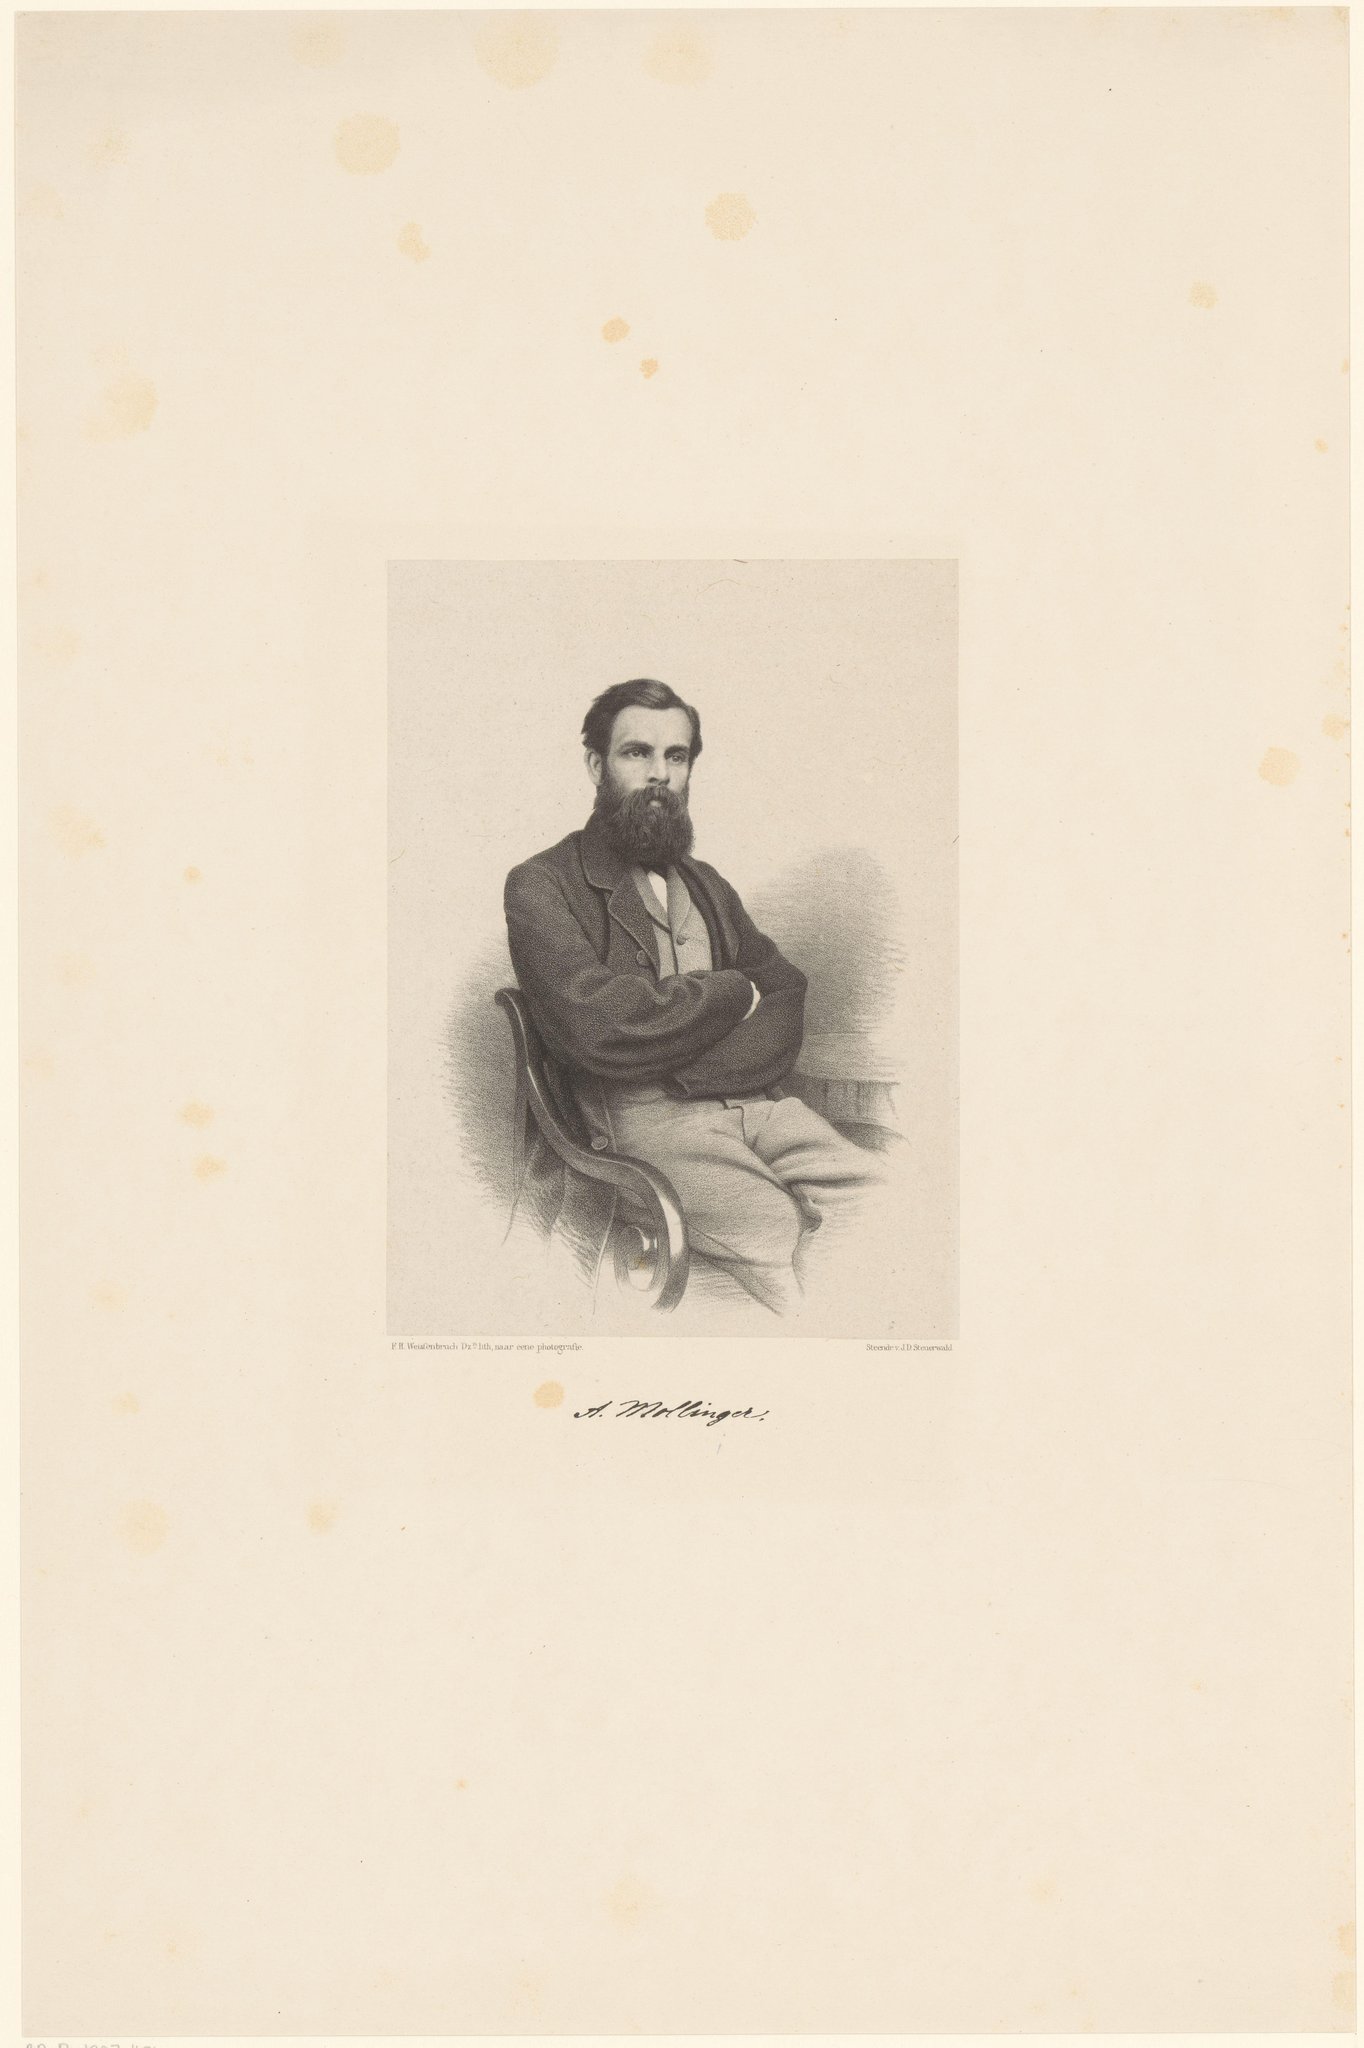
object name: print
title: Portret van Alexander Mollinger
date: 1838-1863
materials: paper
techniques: lithograph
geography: the hague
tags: utrecht, painter, historical persons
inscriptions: collector's mark: Lugt 2228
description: Onder het portret de signatuur van de geportretteerde.